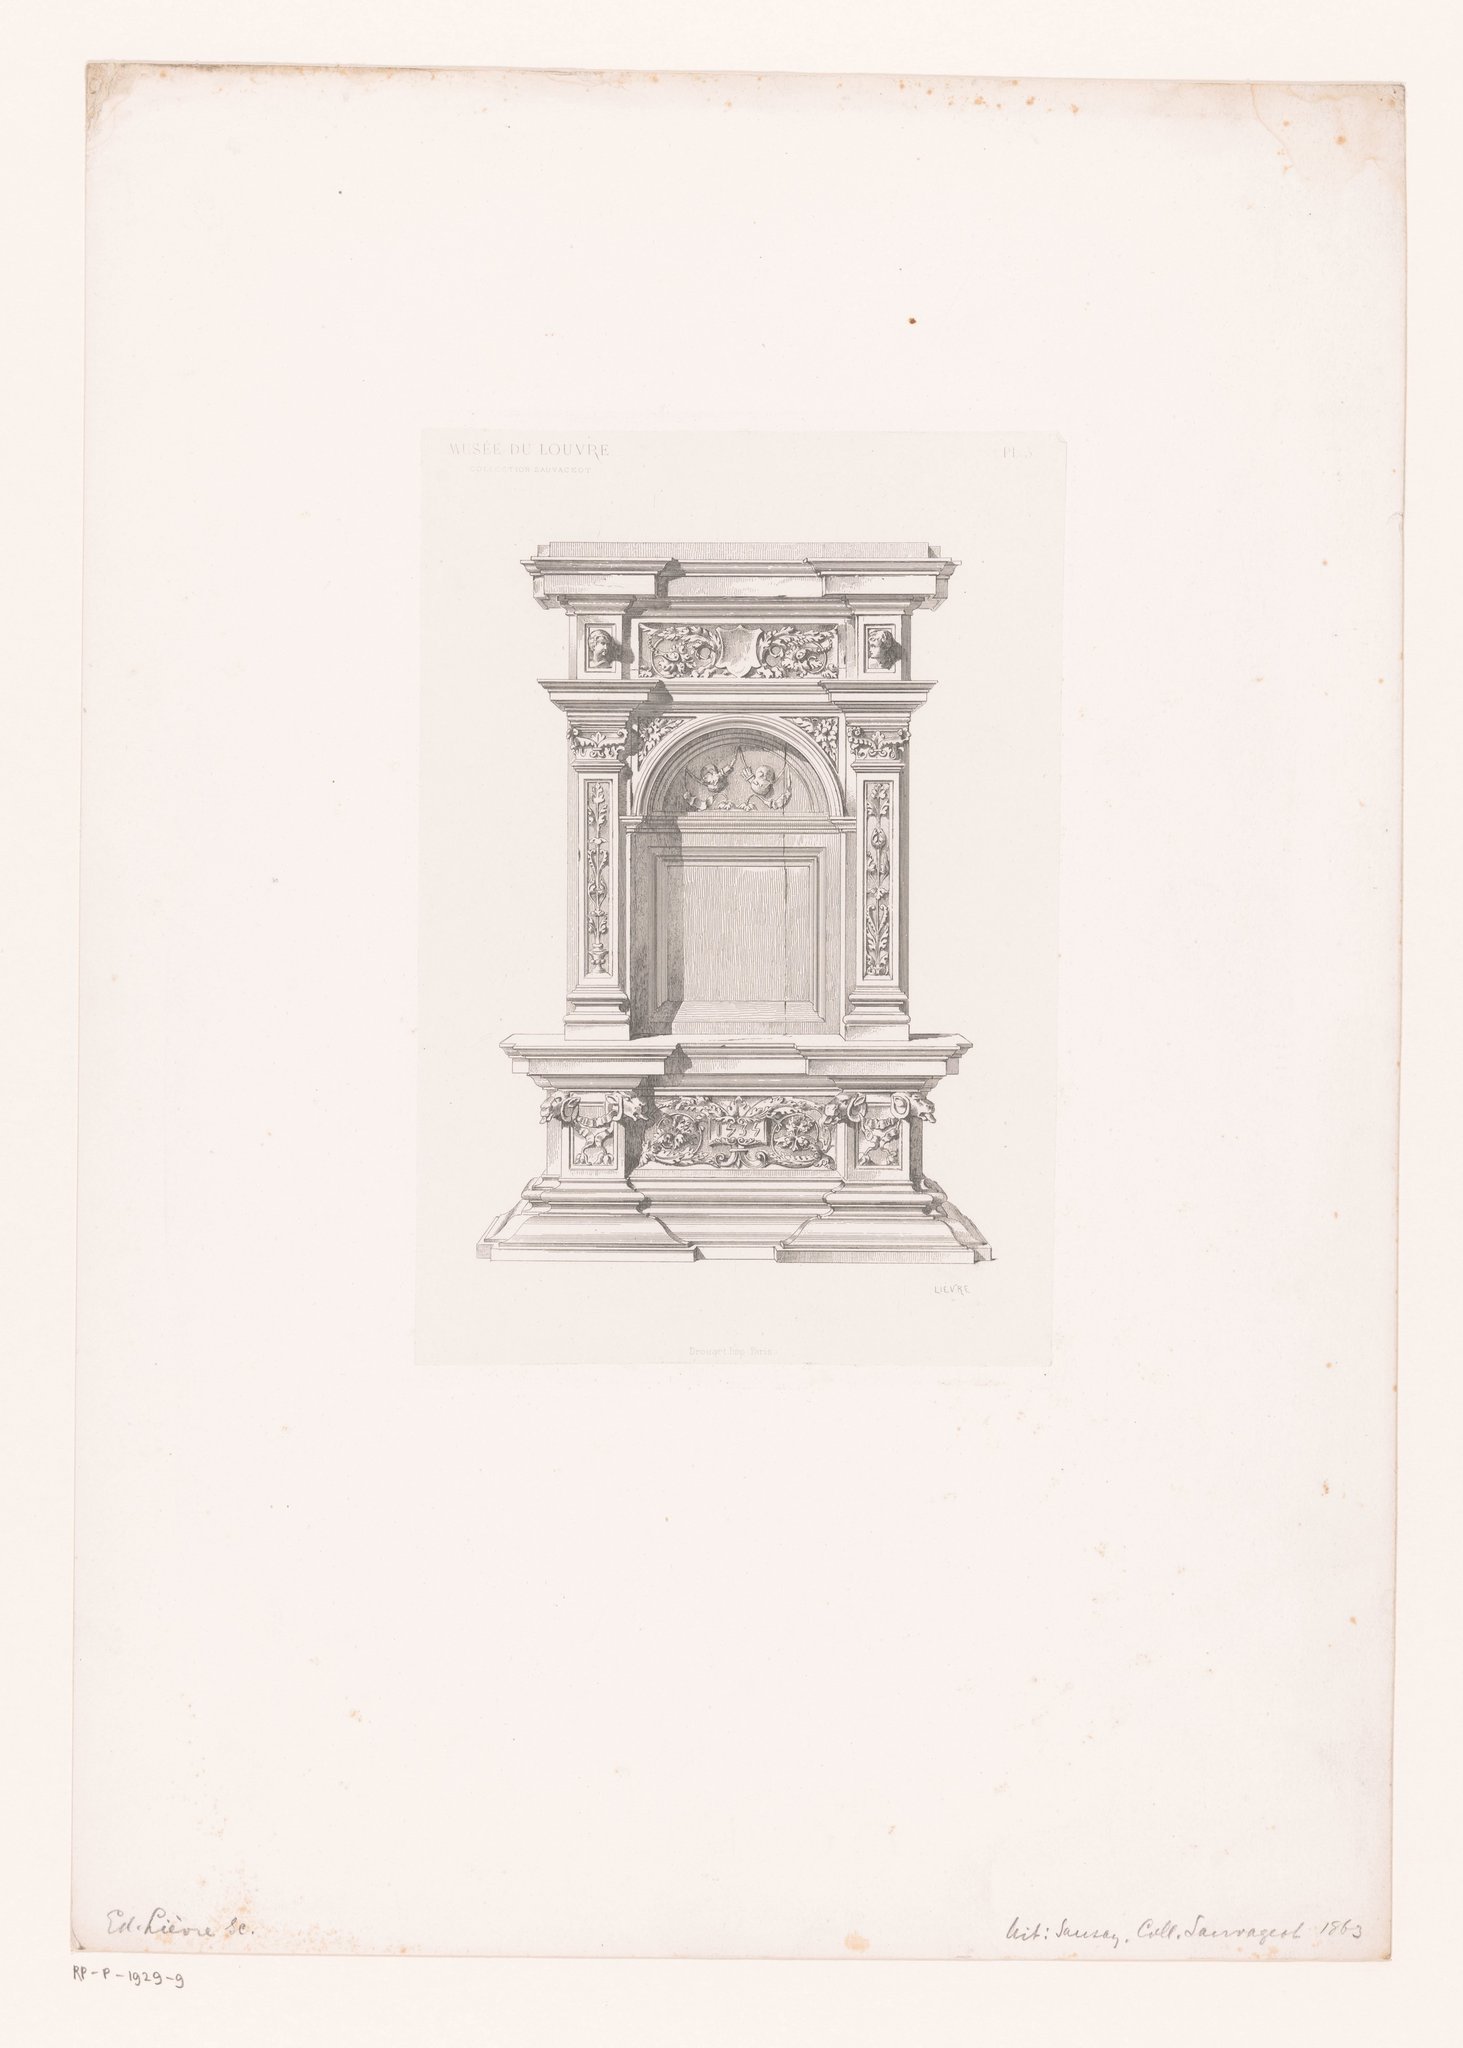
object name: book illustration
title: Architecturaal element met nis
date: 1863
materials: paper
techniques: etching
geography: paris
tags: surface decorations ~ architecture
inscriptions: collector's mark: Lugt 2228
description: Prent uit: Sauzay, Alexandre. Musée Impérial Du Louvre - Collection Sauvageot Dessinée Et Gravée A L'Eau-Forte Par Édouard Lièvre Accompagnée D'Un Texte Historique Et Descriptif Par A. Sauzay. Parijs: Noblet et Baudry, 1863. In deze publicatie worden metalen objecten beschreven uit de Gotiek en de Renaissance uit de collectie van Charles Sauvageot, in 1856 geschonken aan het Musée du Louvre.